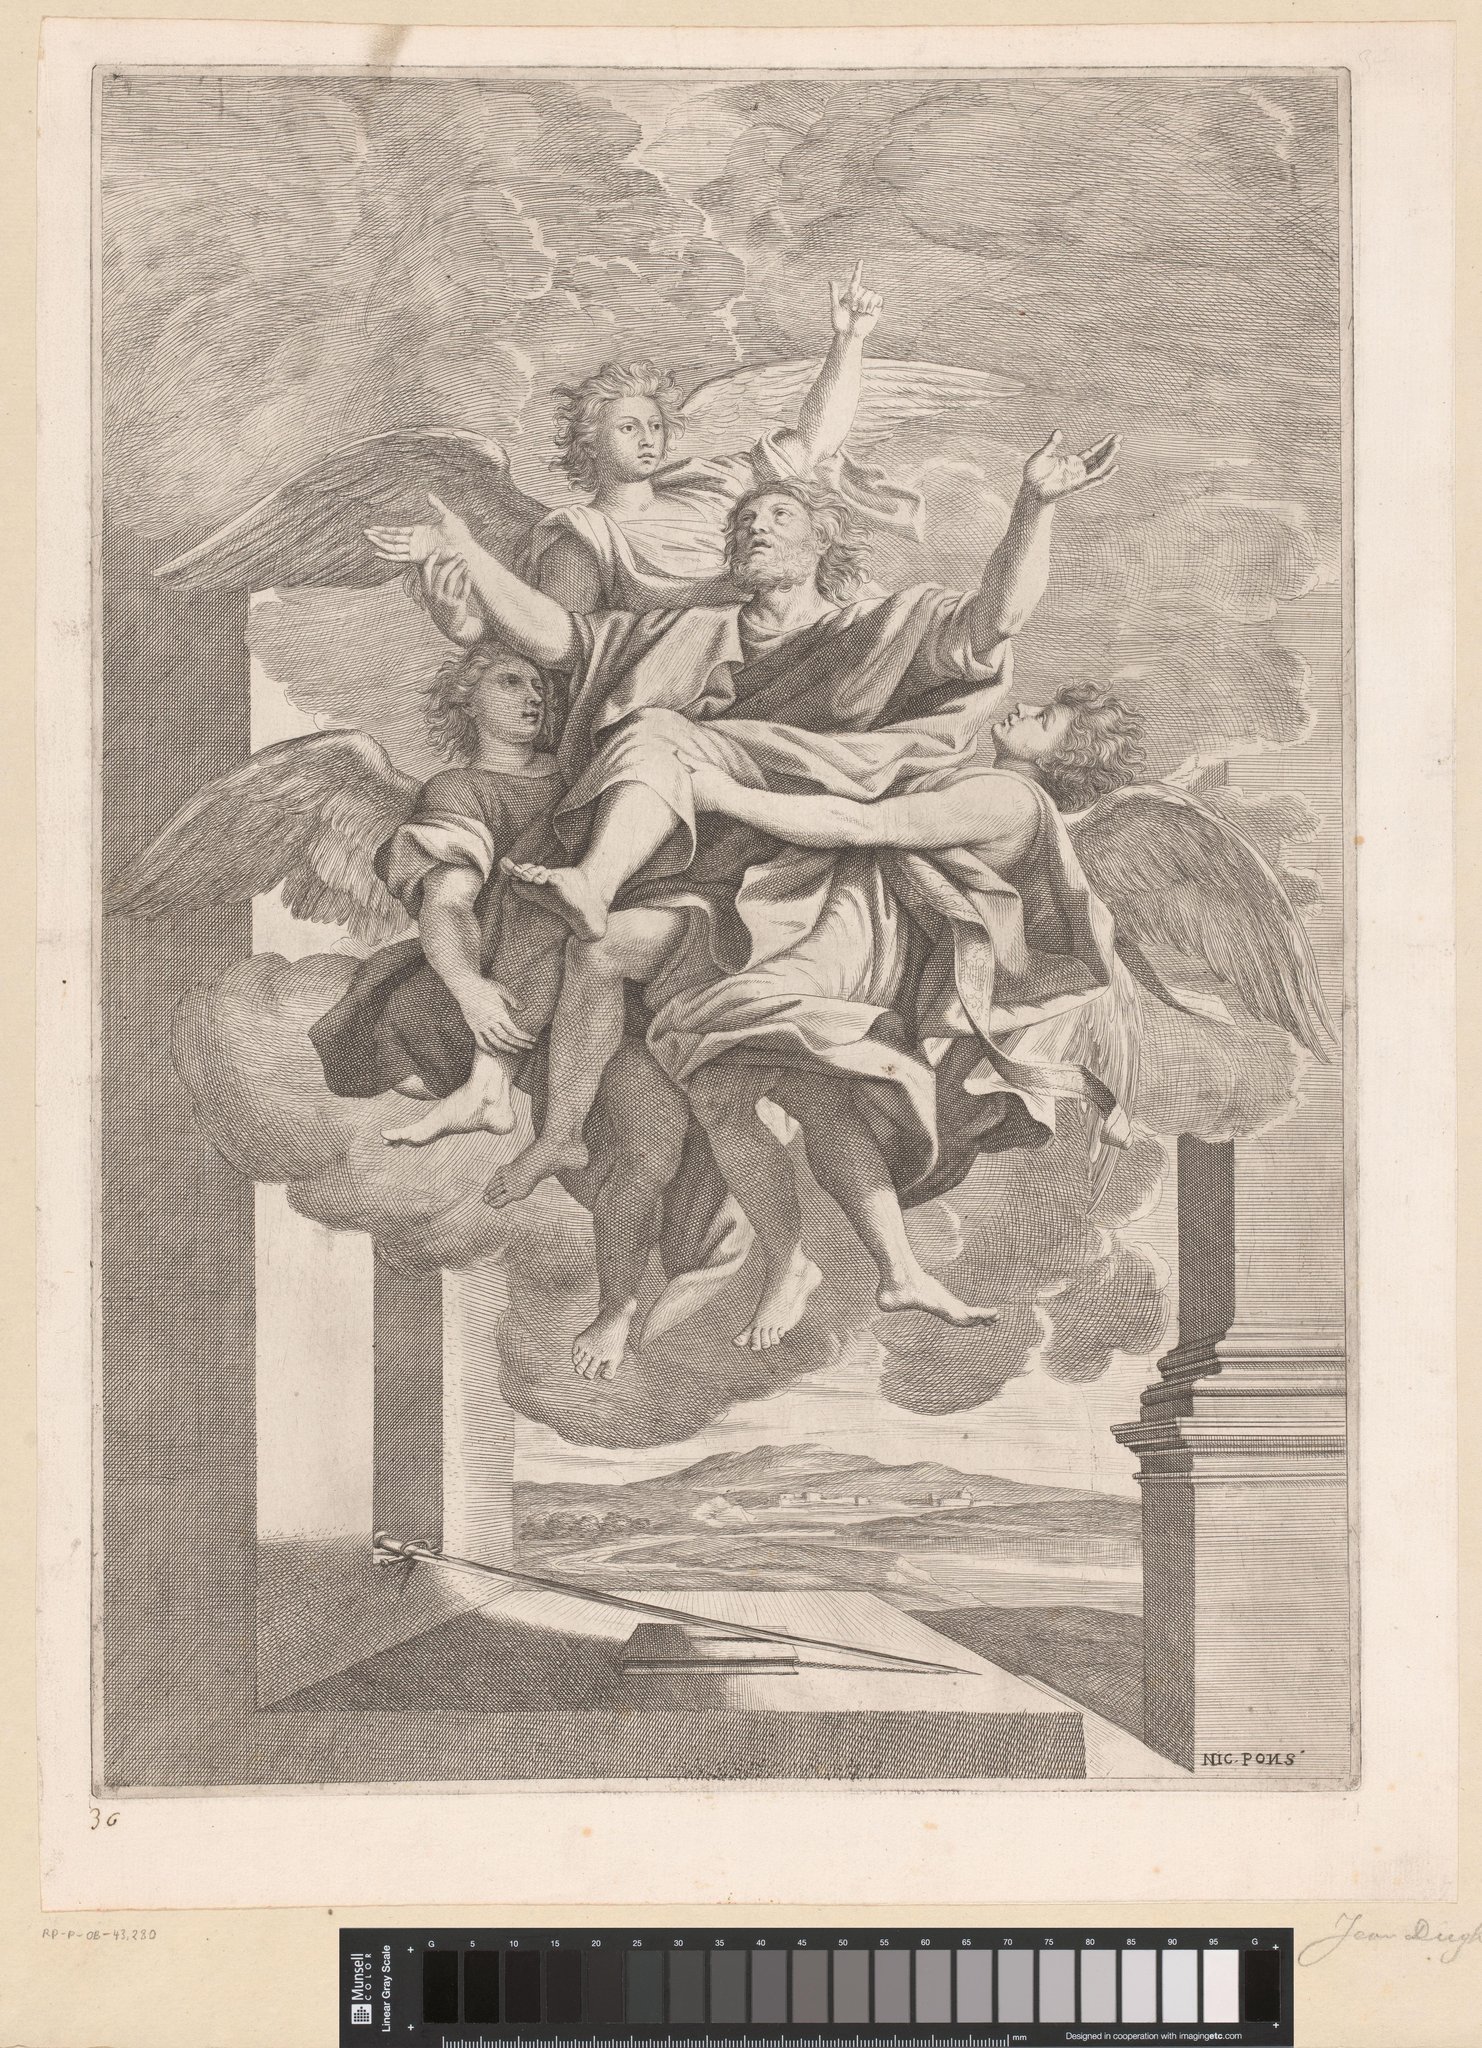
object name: print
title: Extatisch visioen van Paulus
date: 1625-1725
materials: paper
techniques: engraving, etching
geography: france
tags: paul's ecstatic vision: he is borne aloft by (three) angels (2 corinthians 12:1-3)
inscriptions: collector's mark: Lugt 2228